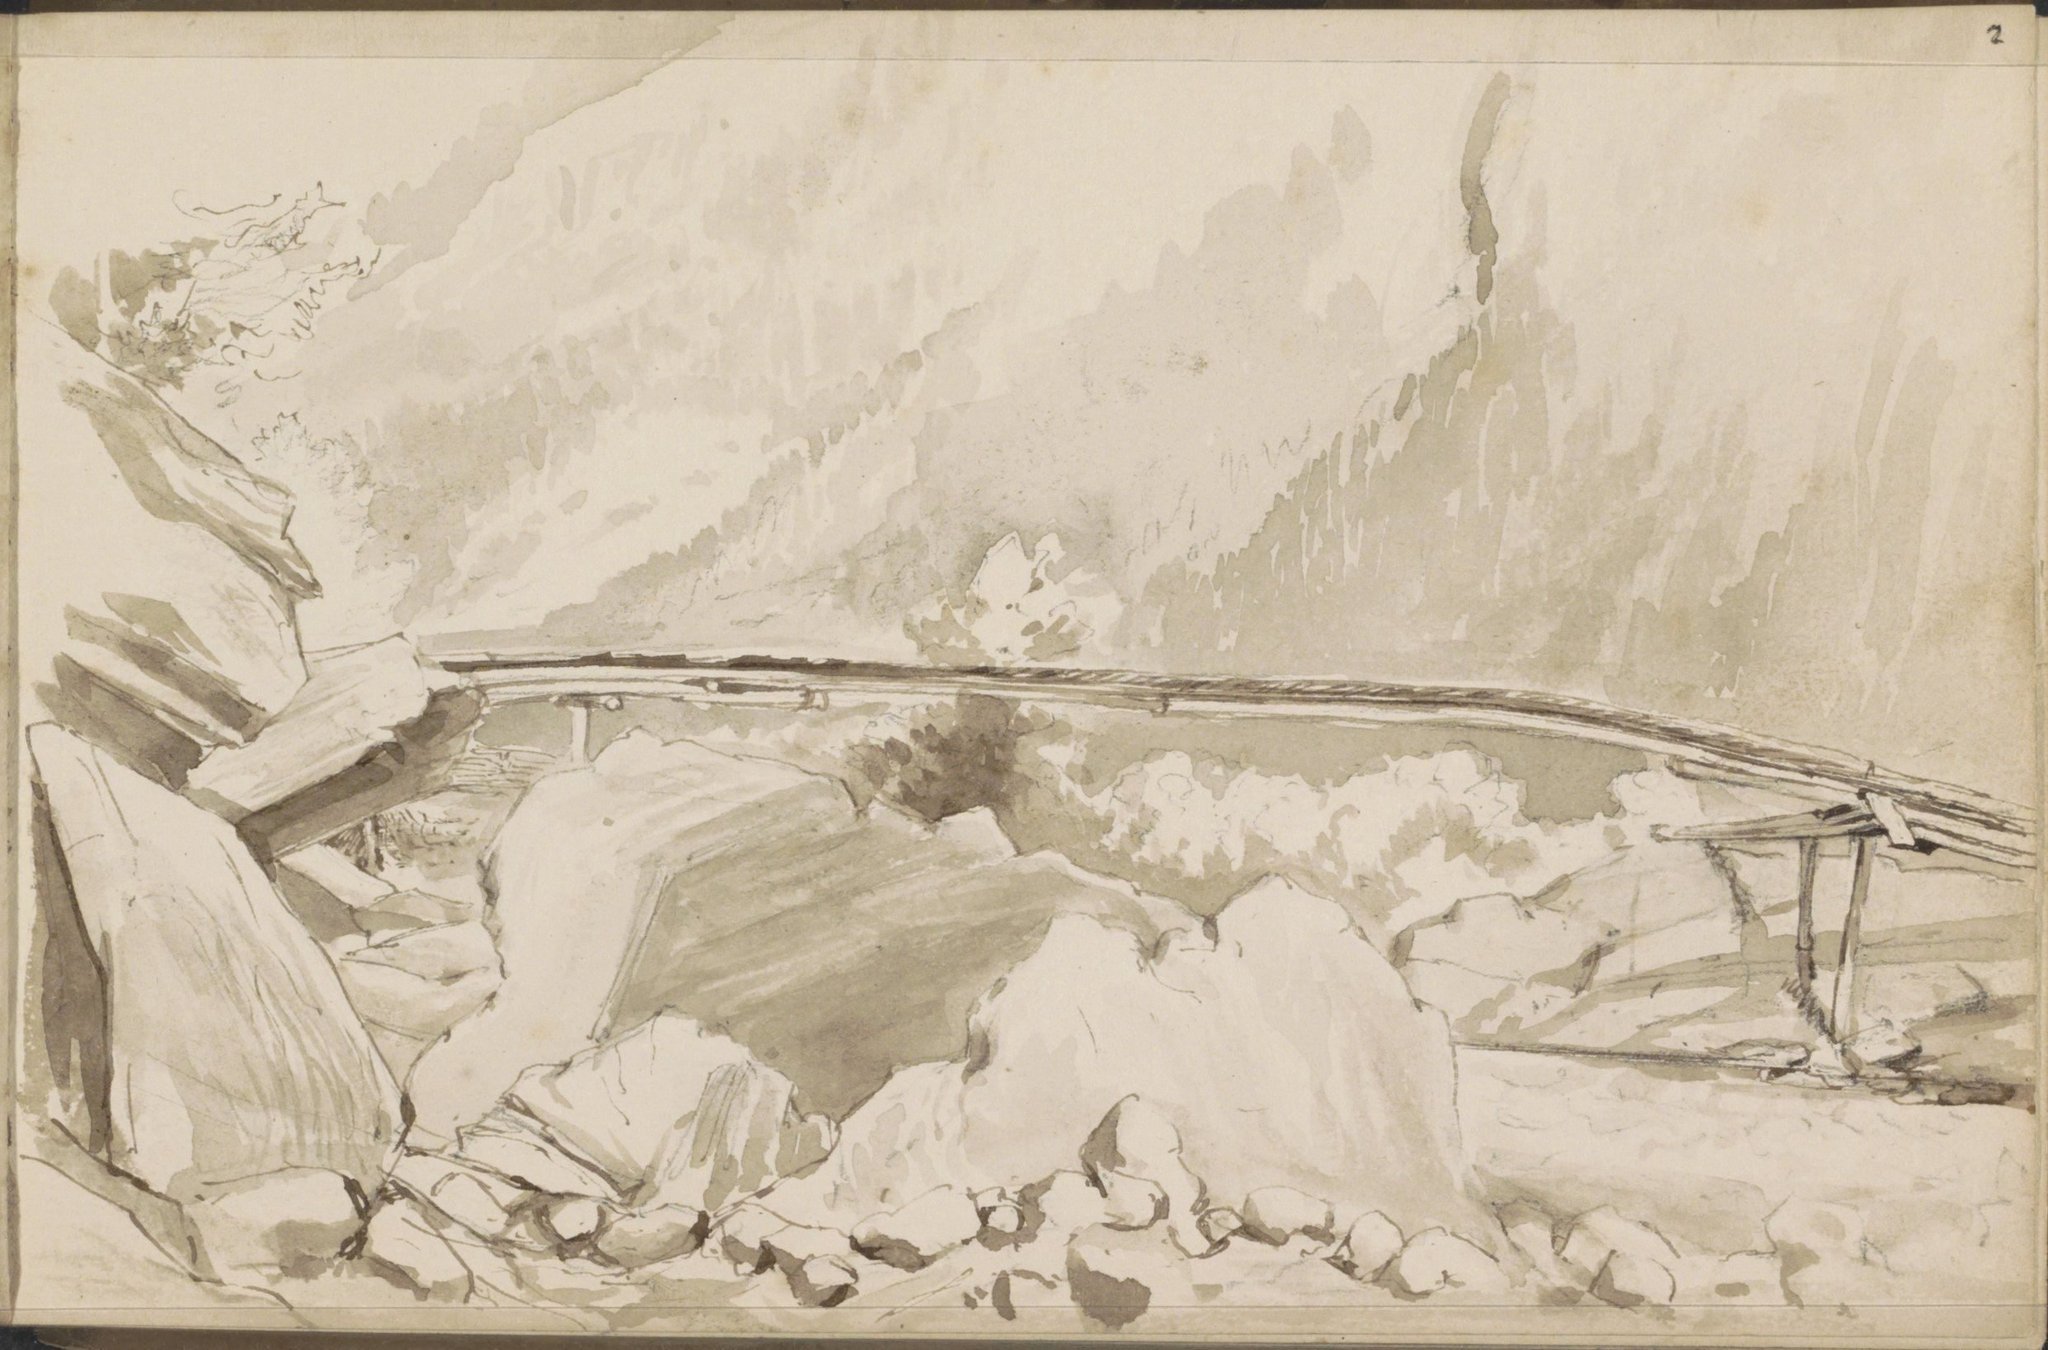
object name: sketchbook leaf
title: Berglandschap met een houten brug over rotsblokken en keien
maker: johannes tavenraat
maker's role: draughtsman, painter, print maker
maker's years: 1809-1881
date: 1808-1858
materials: ink, paper, pencil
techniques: brush, pen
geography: tirol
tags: bridge, rocks, mountains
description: Blad 2 recto uit een schetsboek met 48 bladen.